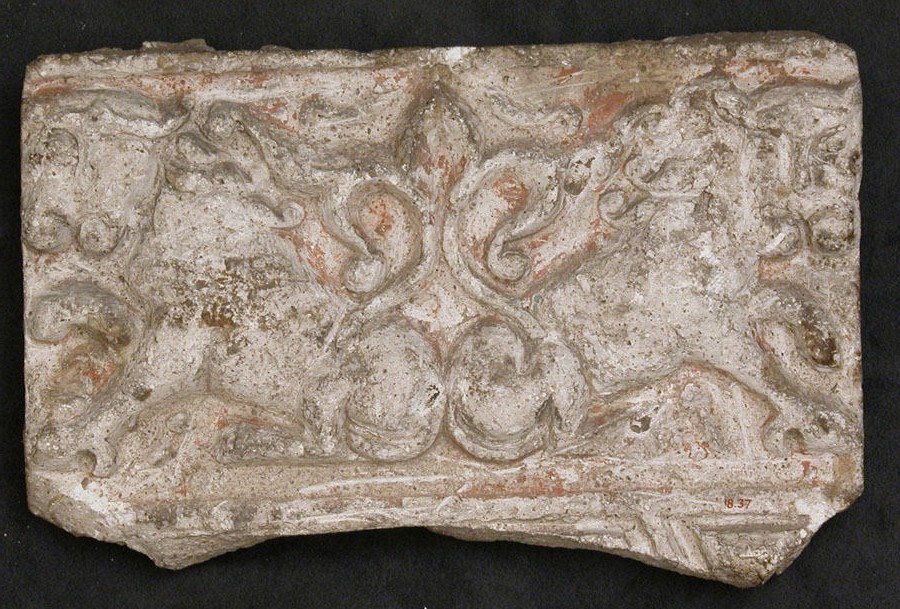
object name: frieze fragment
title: Fragment of a Frieze with Addorsed Lions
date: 1101-1200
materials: gypsum, plaster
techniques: molding, painting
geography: iran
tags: lions